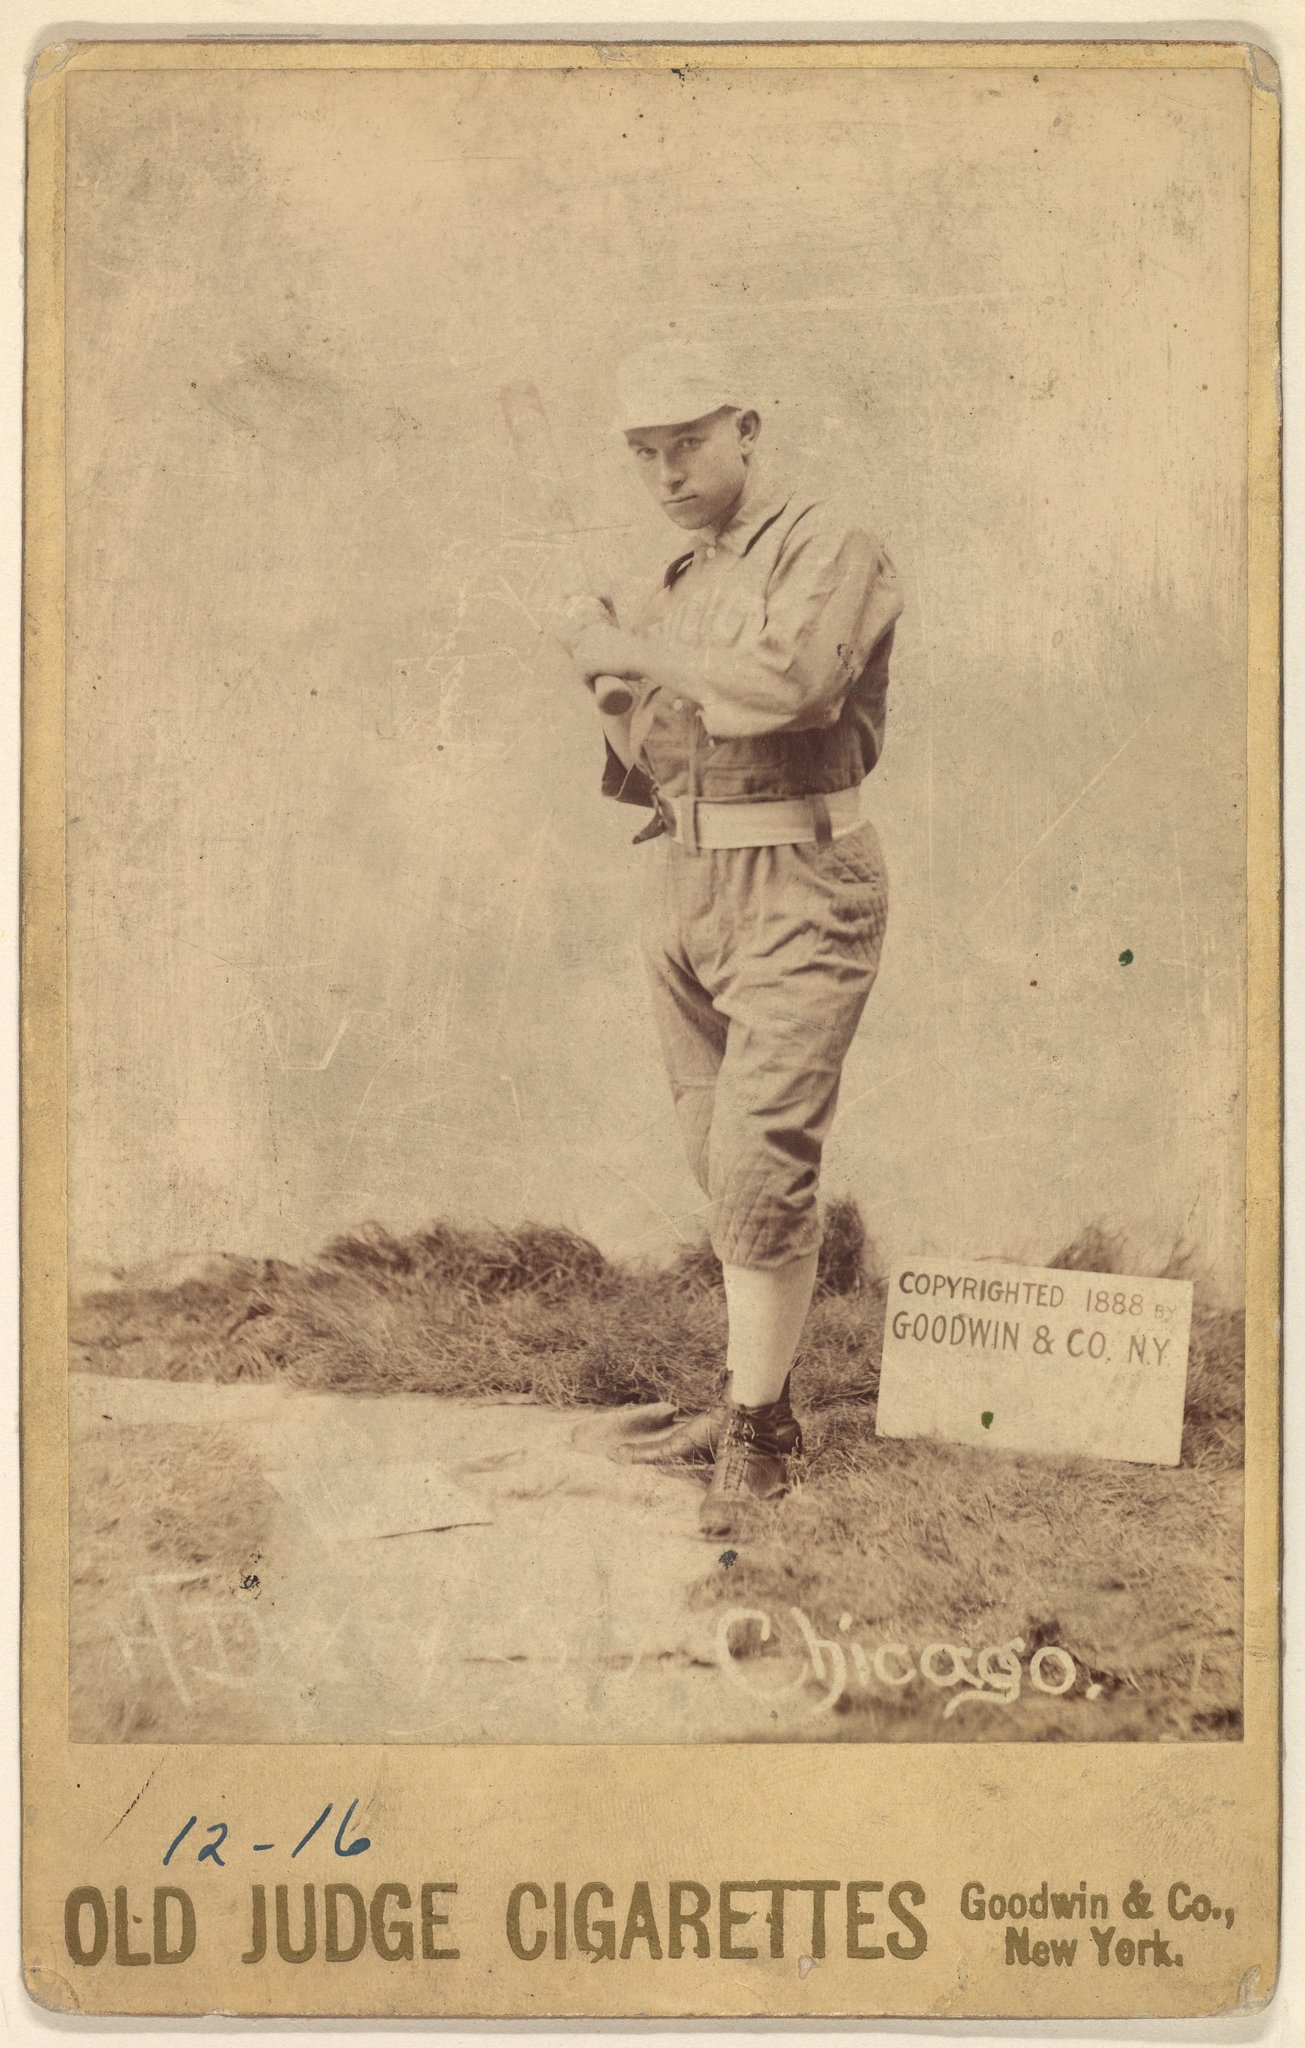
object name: baseball card, photograph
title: Chicago, from the series Old Judge Cigarettes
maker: goodwin & company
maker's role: publisher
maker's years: 1850-1950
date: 1888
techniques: albumen silver print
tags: men,portraits,baseball,athletes